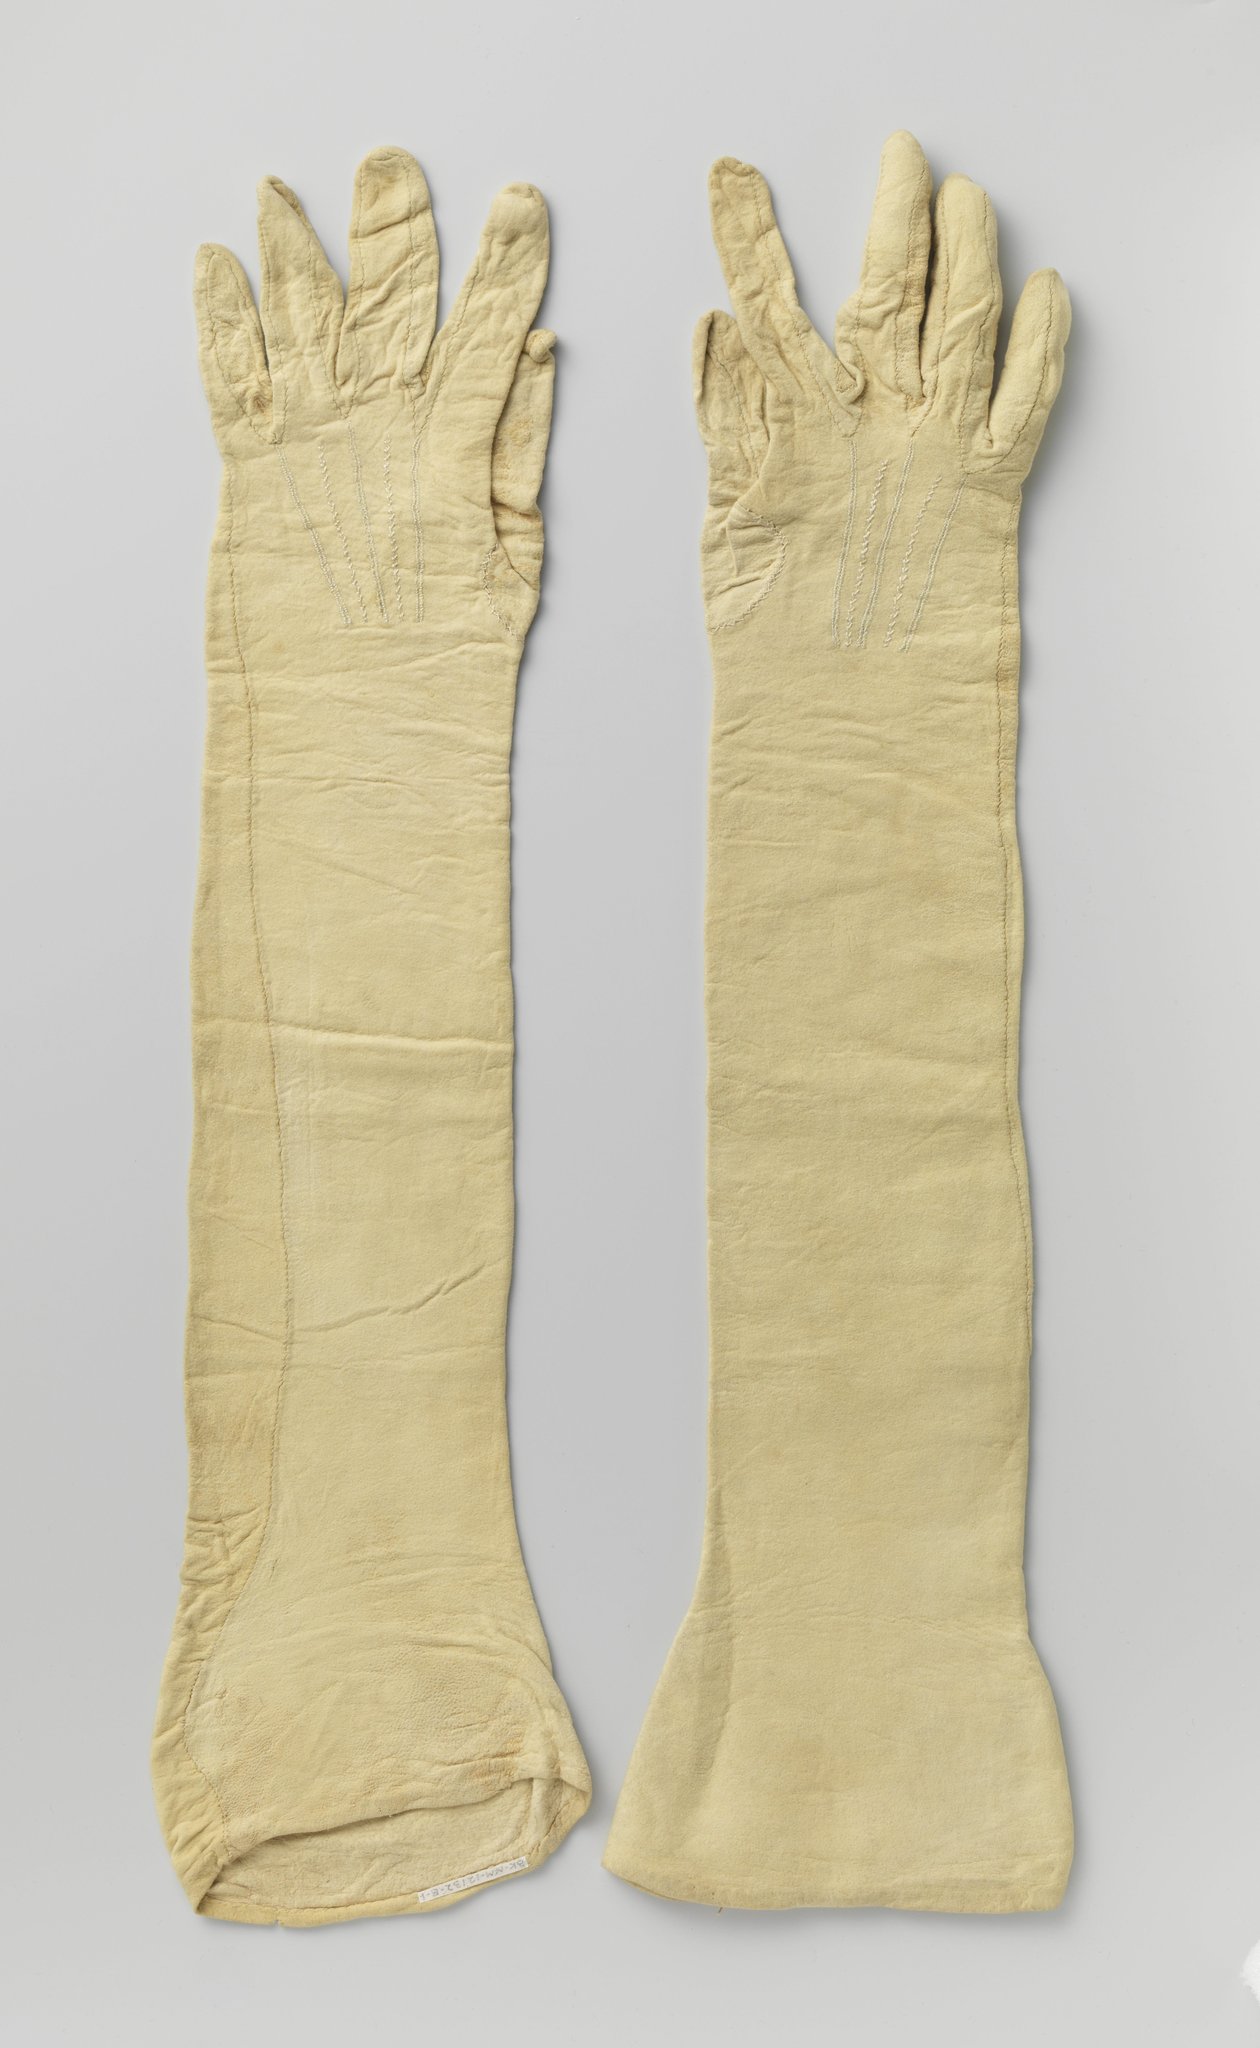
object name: glove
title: Handschoen van beige zeemleer met op de rug vijf geborduurde uitstralende koorden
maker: Anonymous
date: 1800-1850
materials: leather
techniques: embroidered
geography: western europe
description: Rechter handschoen van beige zeemleer, met op de rug vijf geborduurde koorden in twee verschillende motieven, langs de duim afgezet met flanelsteek.